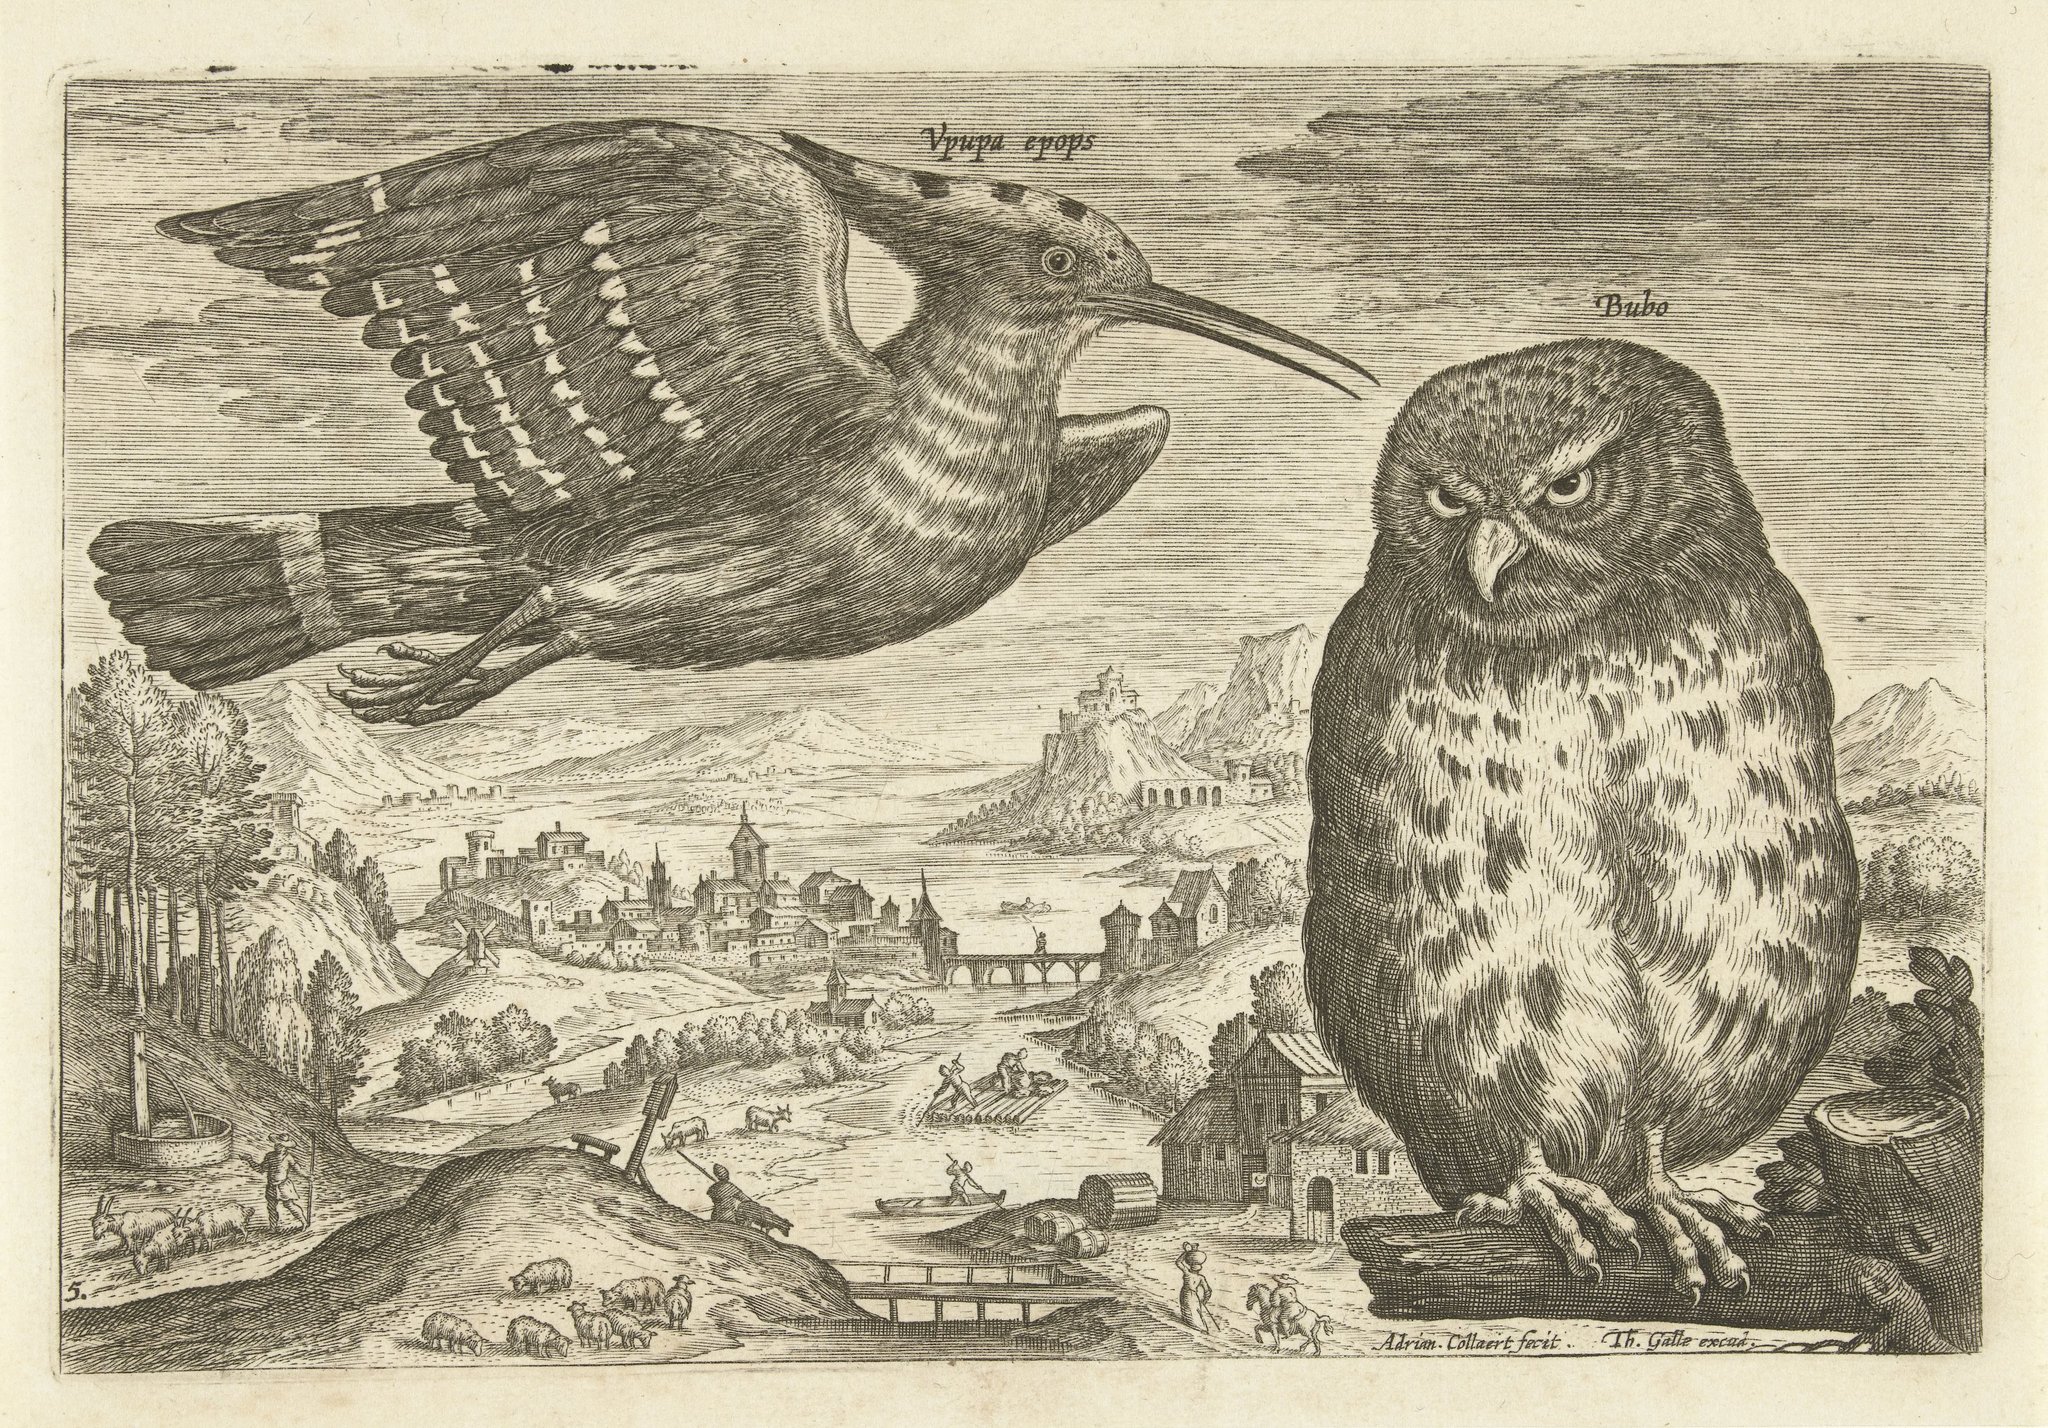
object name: print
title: Vogels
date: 1598-1600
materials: paper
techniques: engraving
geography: antwerp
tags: other birds: hoopoe, owls, river (+ landscape with figures, staffage)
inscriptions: collector's mark: Lugt 2228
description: Een Hop en een uil in een landschap met een rivier. De prent maakt deel uit van een serie met vogels als onderwerp.